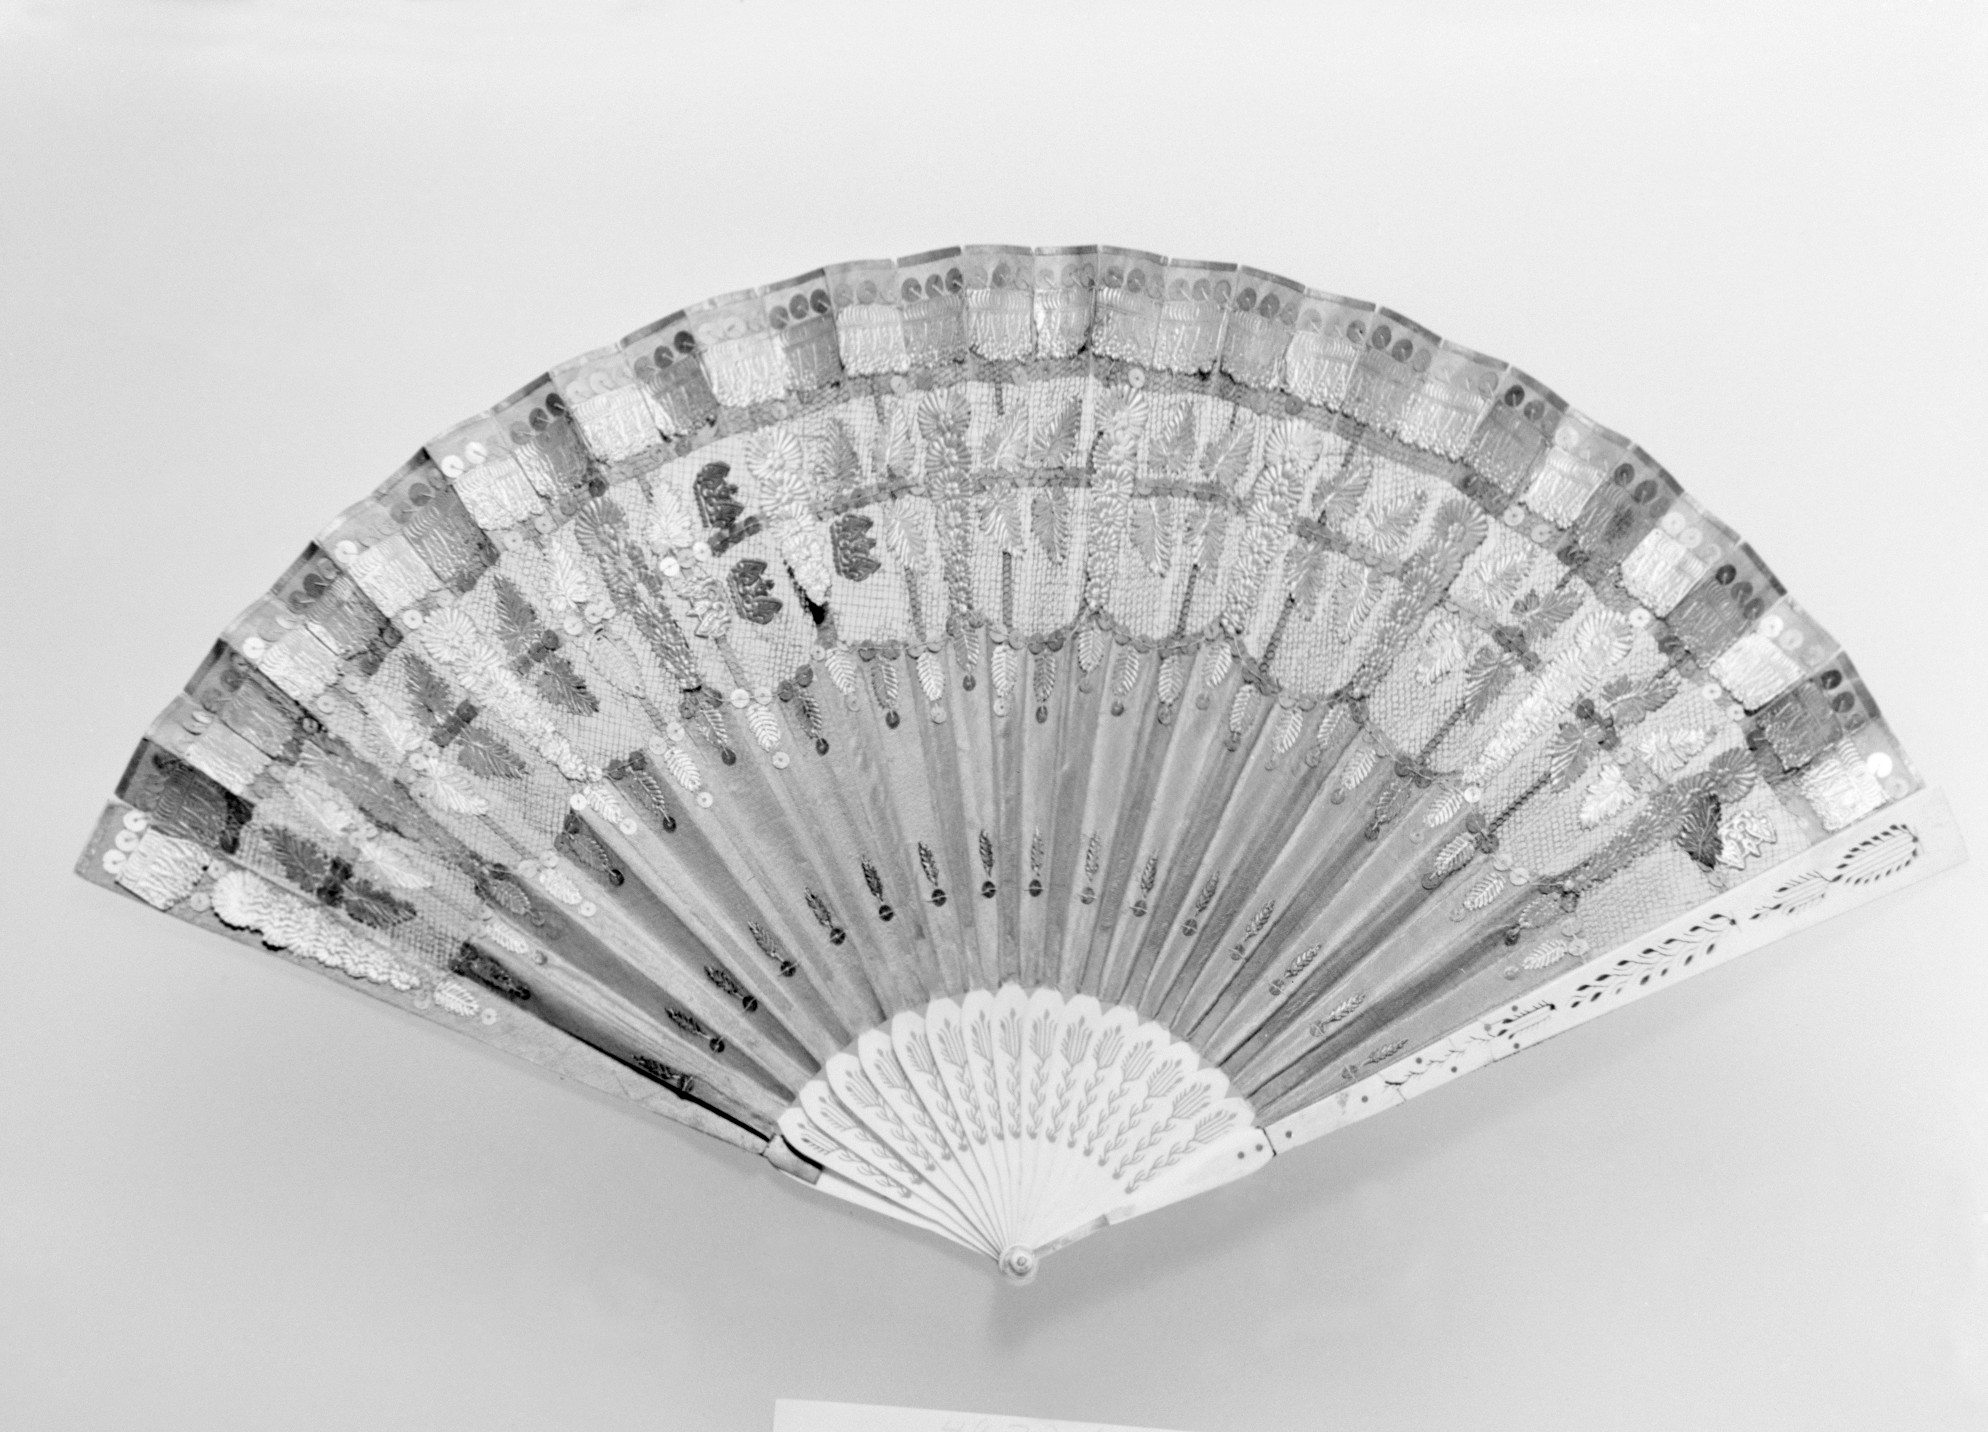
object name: fan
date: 1800-1833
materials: brass, gold, ivory, paper, silk